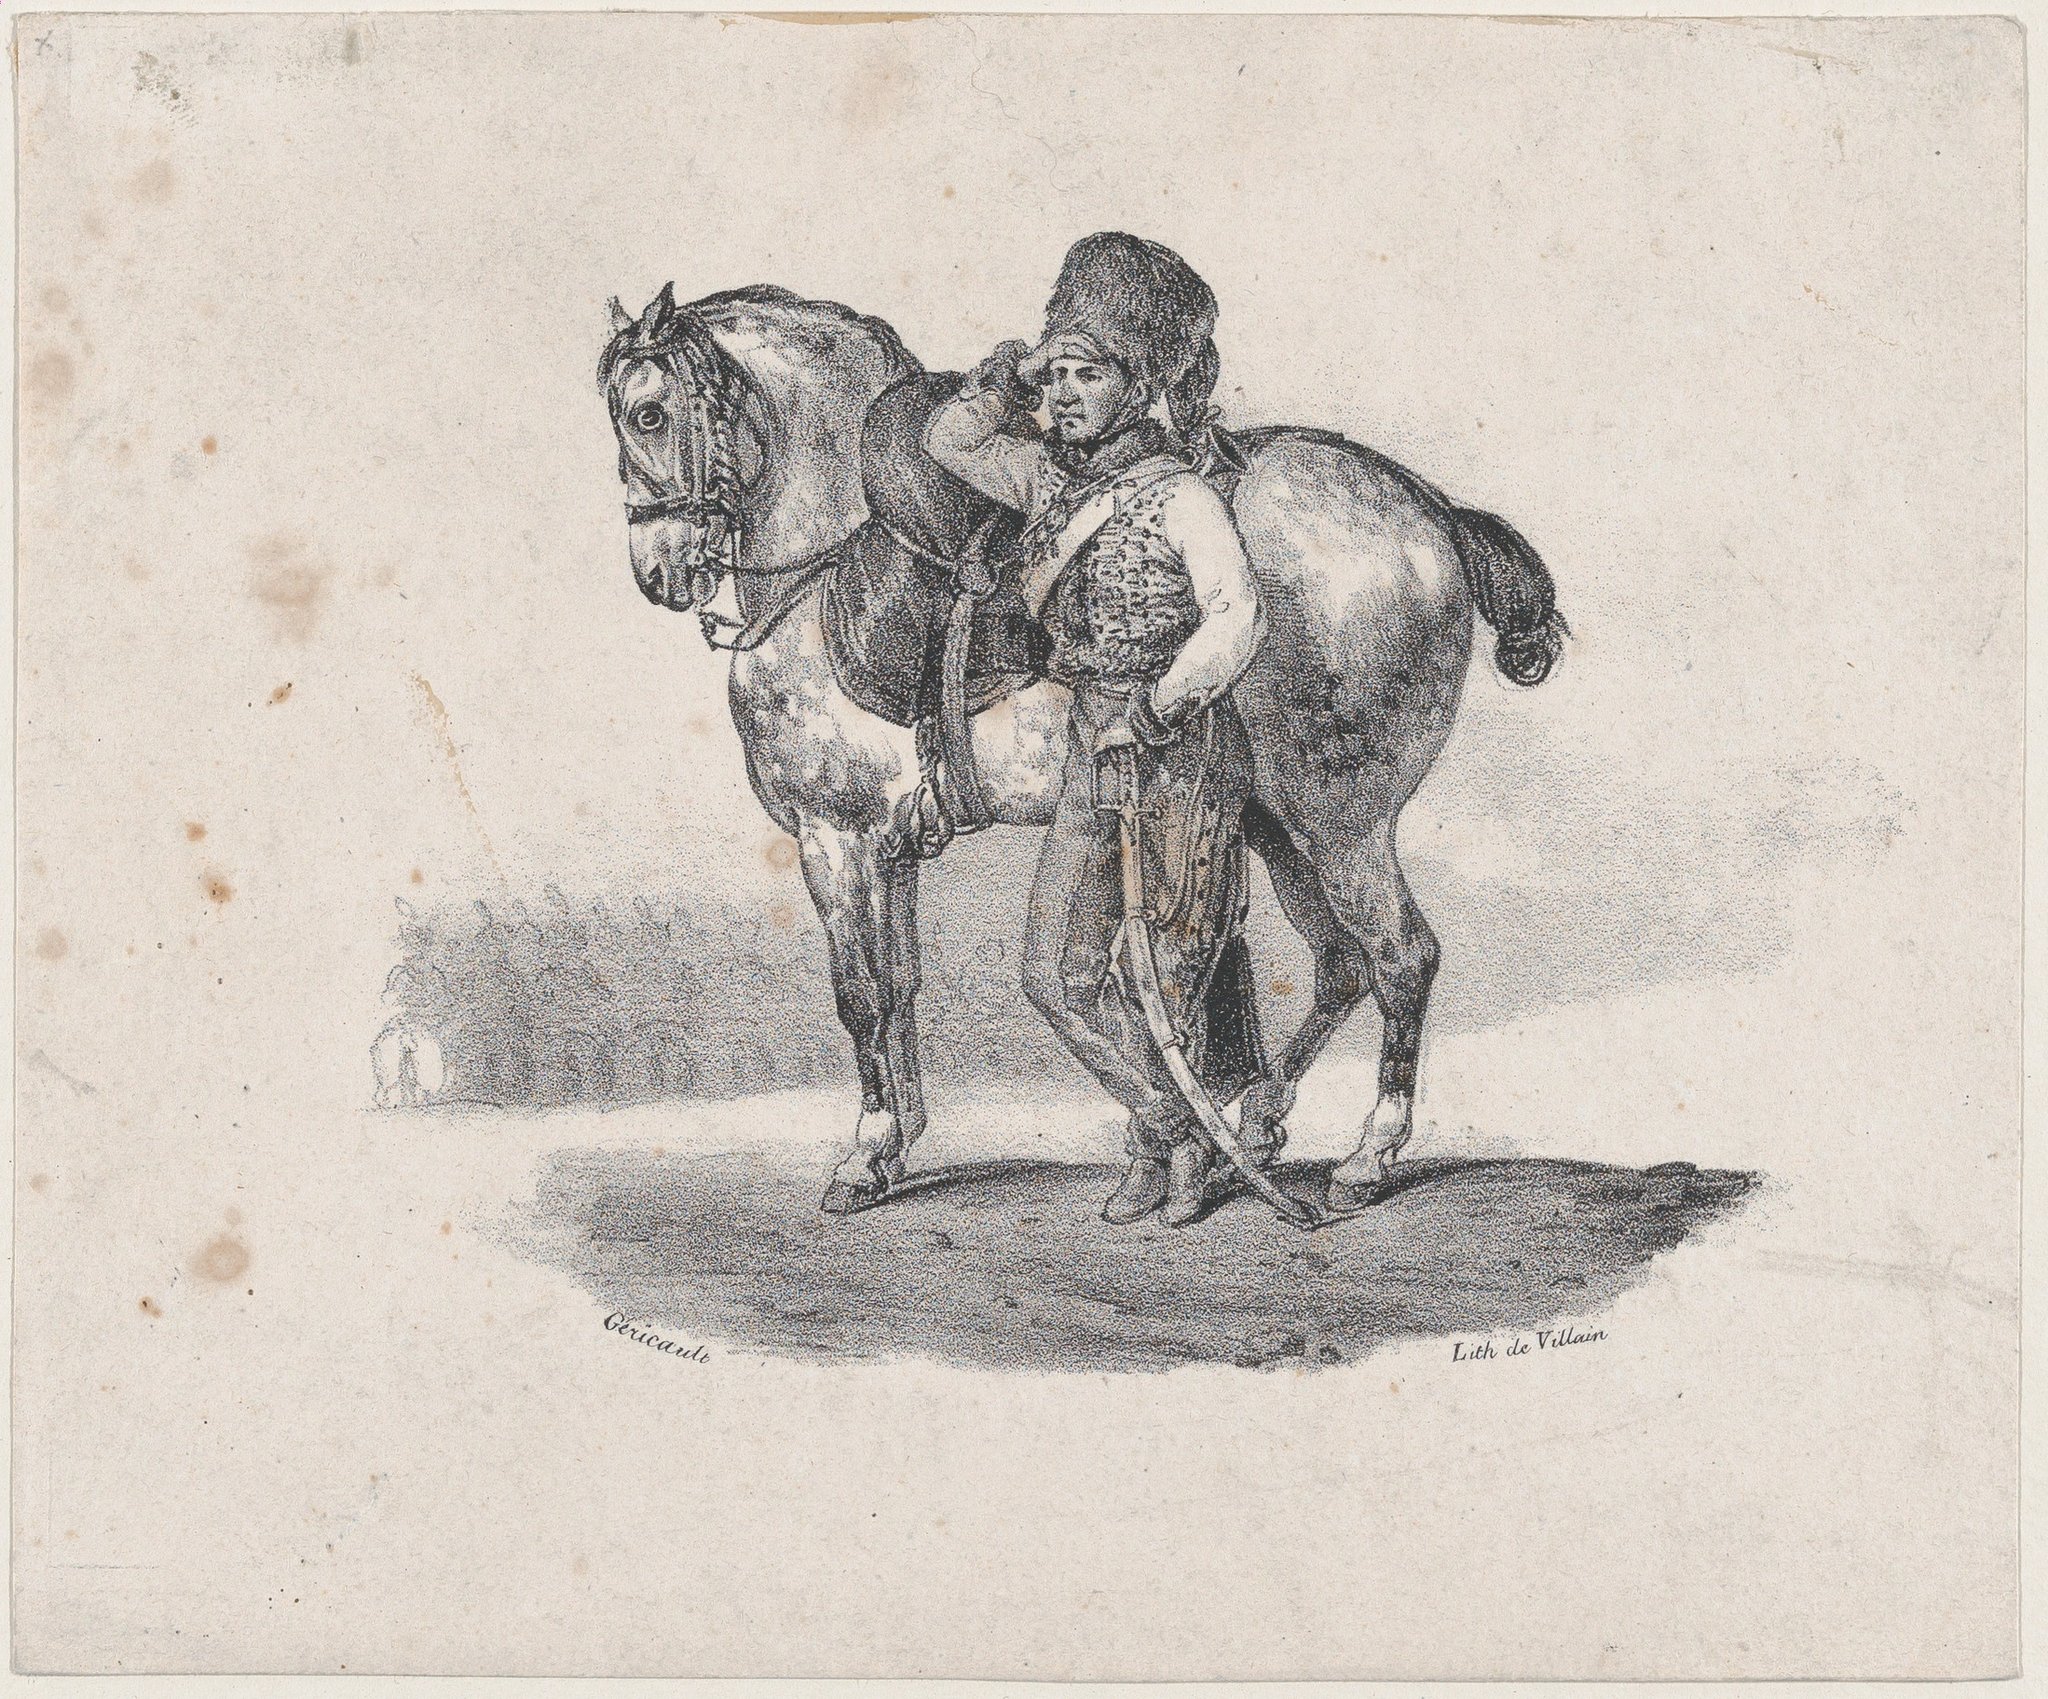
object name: print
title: The Trumpet of the Hussards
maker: jean louis andré théodore géricault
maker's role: artist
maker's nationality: french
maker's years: 1791-1824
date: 1823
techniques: lithograph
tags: swords,men,horses